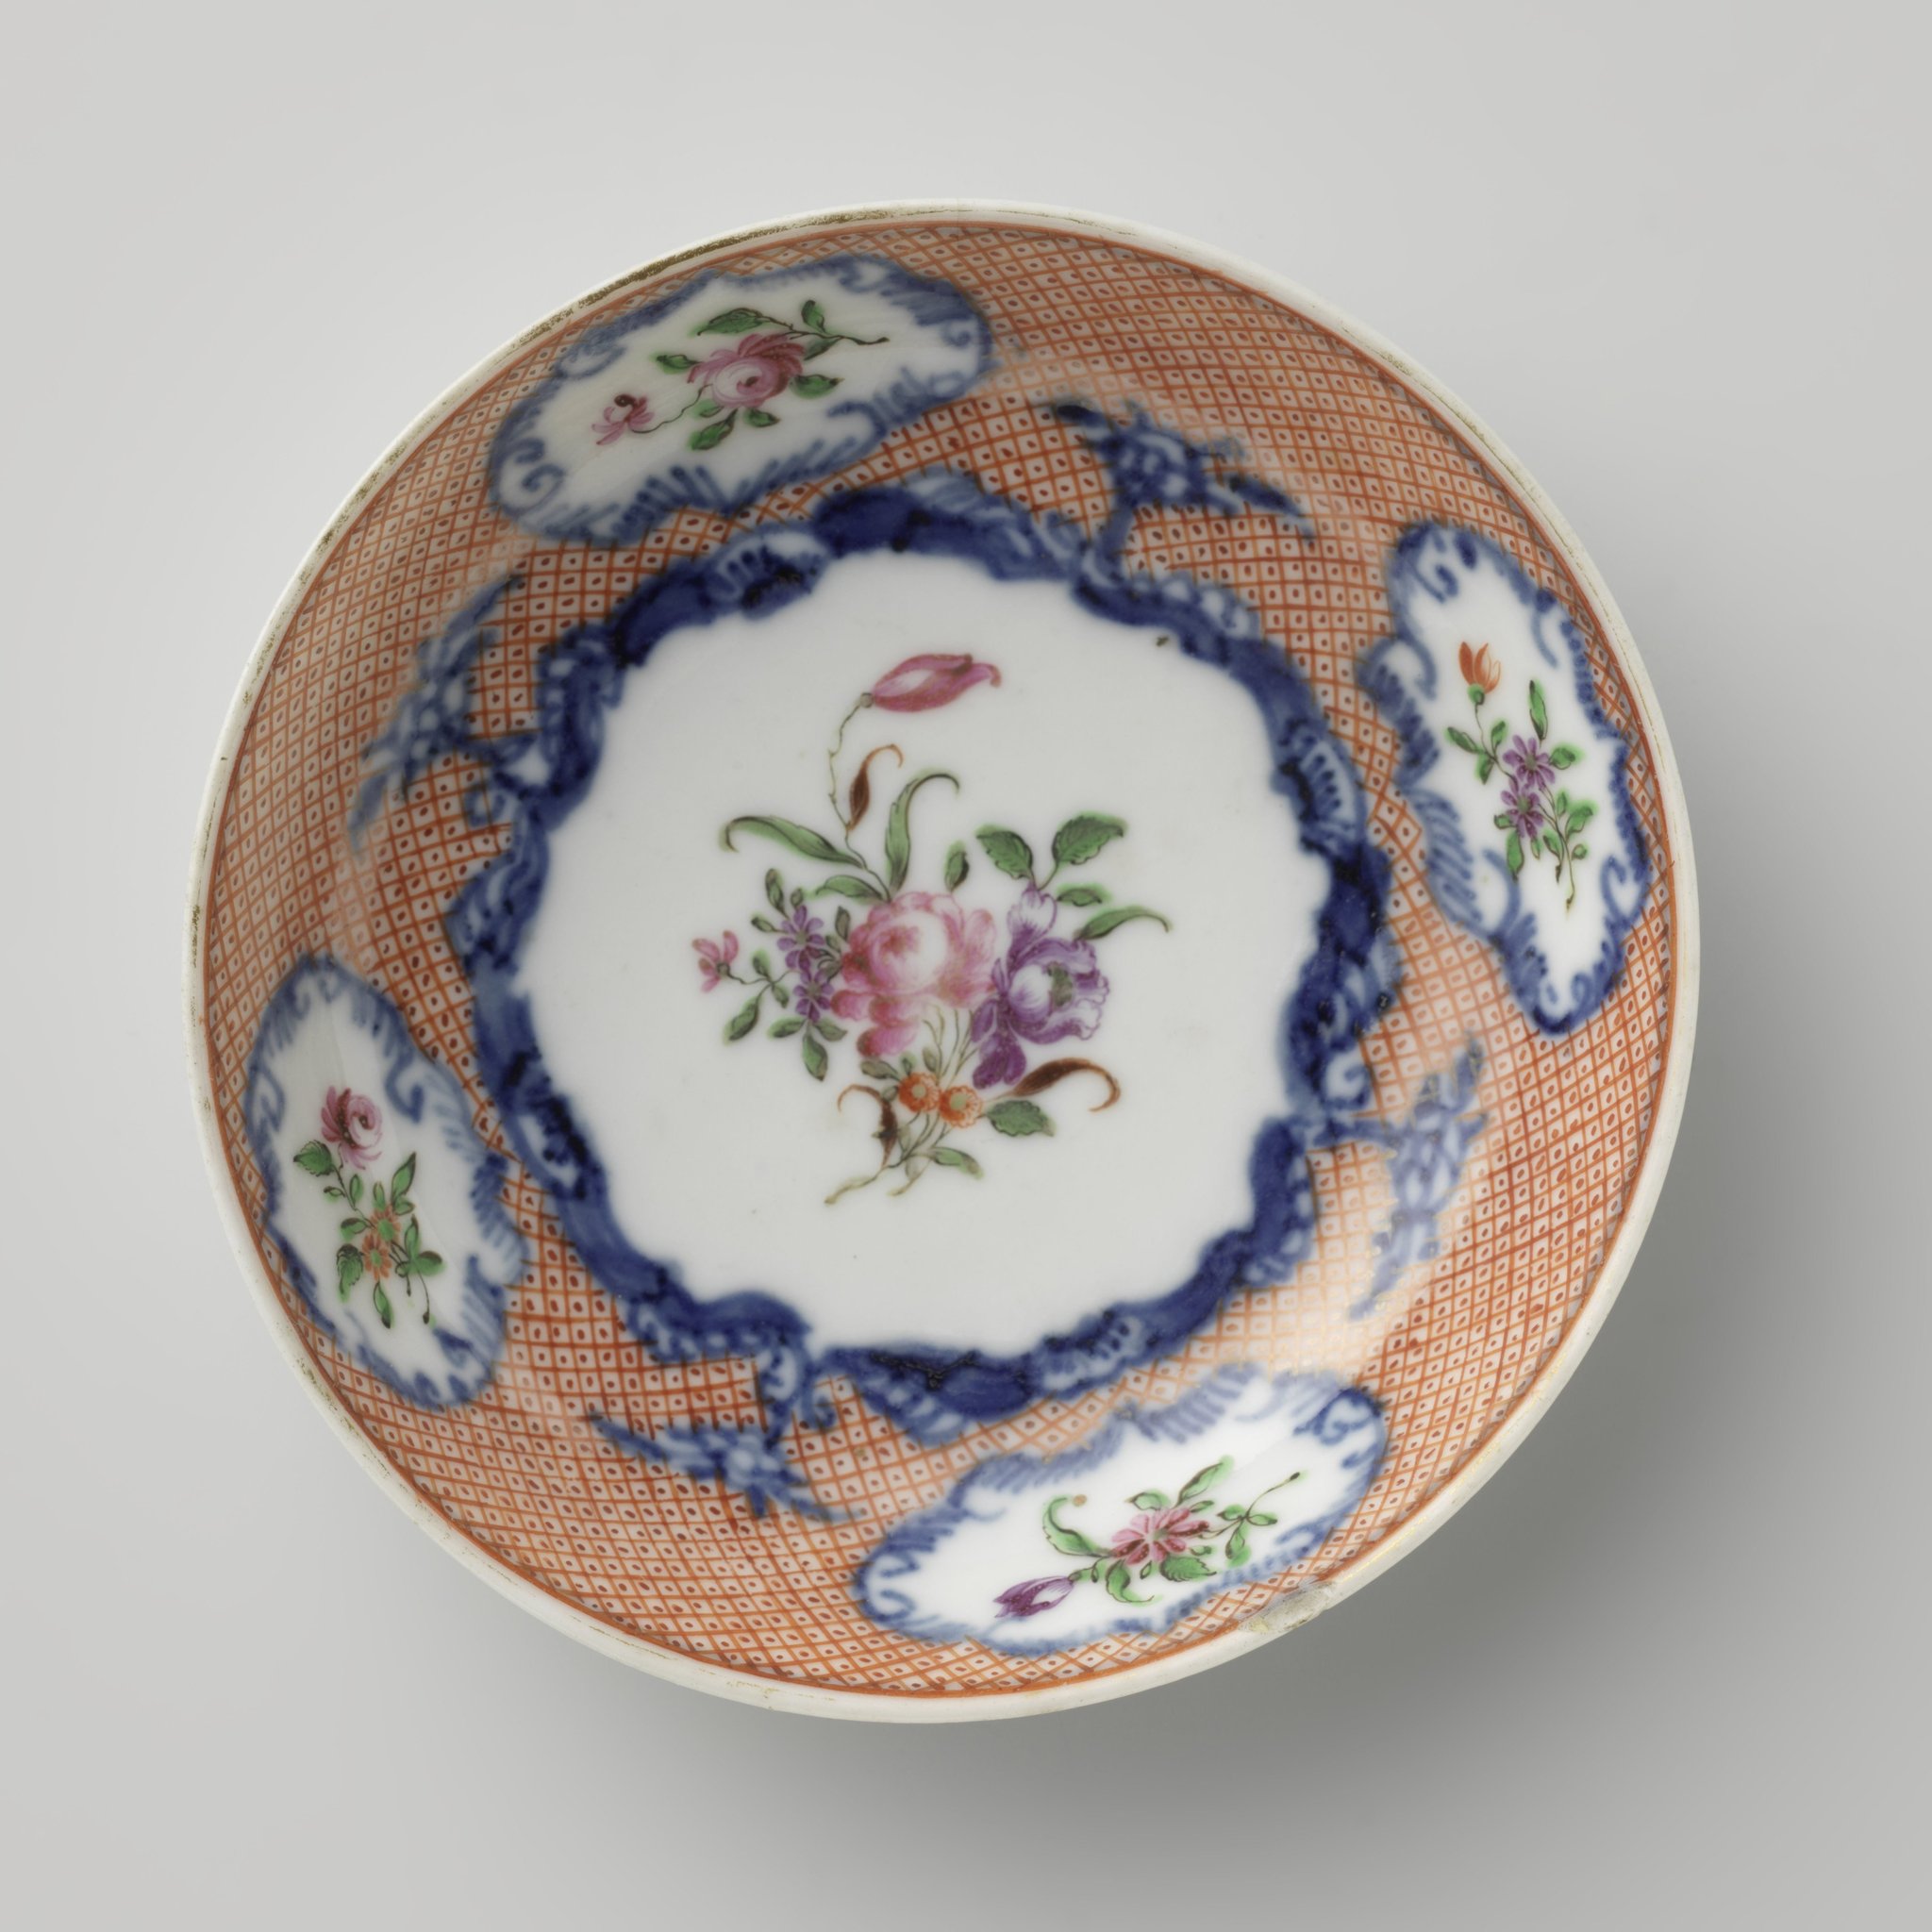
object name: kop en schotel, kop en schotel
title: Saucer with flower sprays in panels on a ground of red diaper pattern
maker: Anonymous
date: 1750-1774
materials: cobalt, glaze, paint, porcelain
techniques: firing, turning, vitrification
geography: china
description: Schotel van porselein met rechte wand, beschilderd in onderglazuur blauw en op het glazuur rood, roze, groen, paars en zwart. Op het plat van de schotel een cartouche in onderglazuur blauw met een bloemtak; de binnenwand met rood servetwerk met hierin uitgespaard vier kleinere cartouches met bloemtak. Een chip in de rand van de schotel. Famille rose.